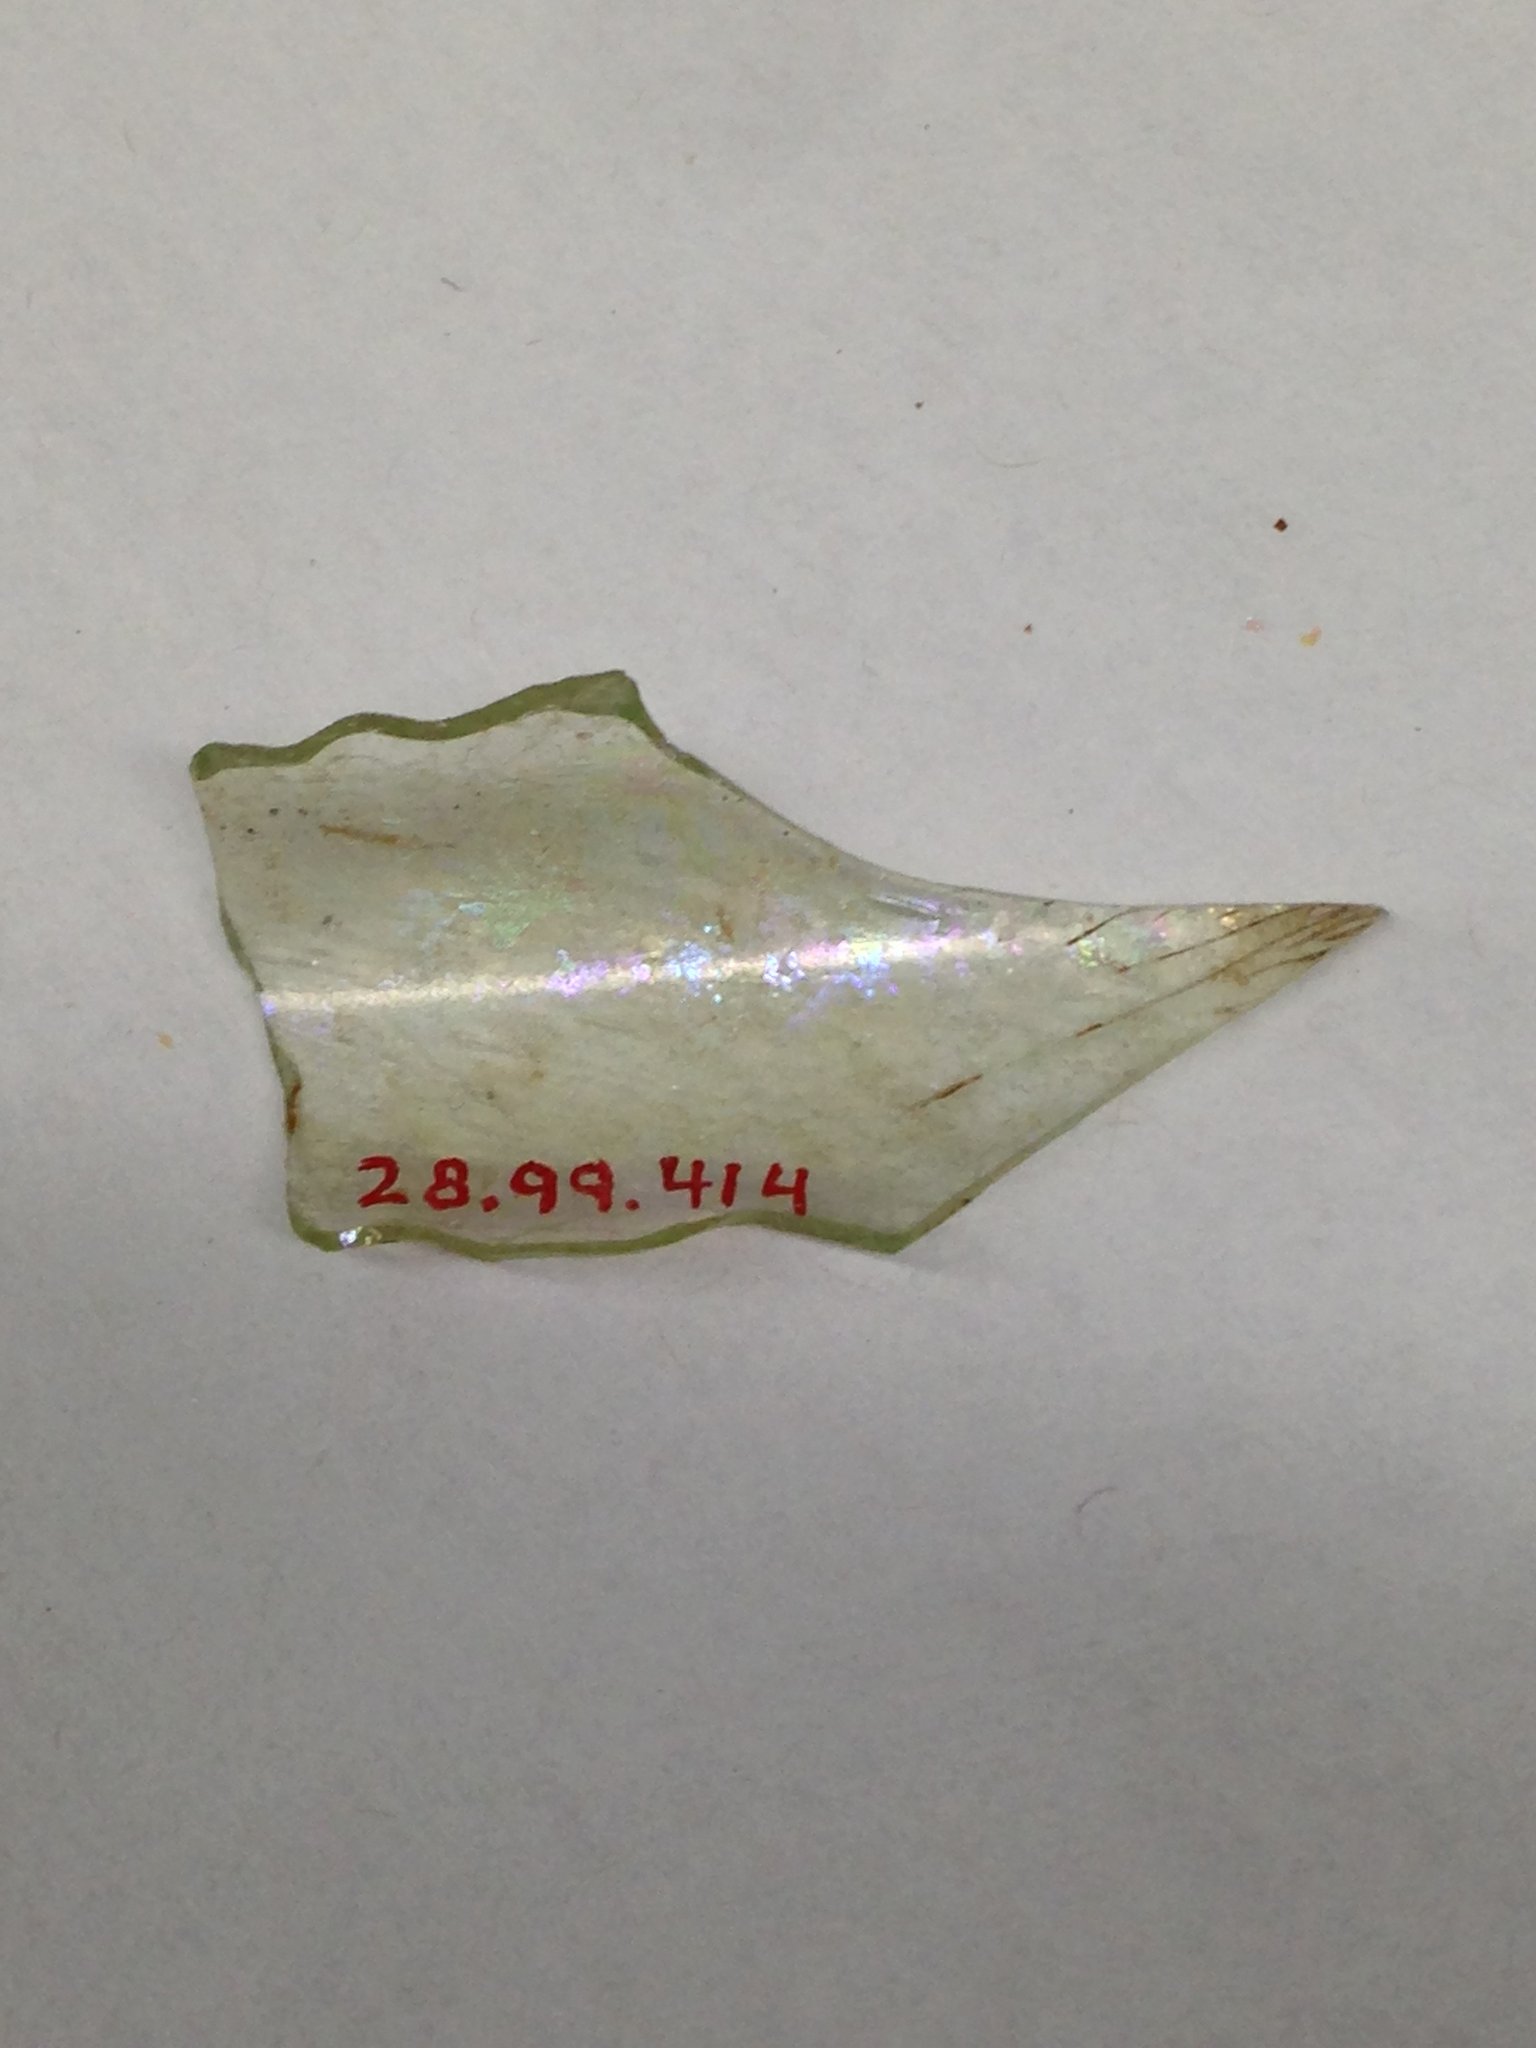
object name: fragment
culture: european or middle eastern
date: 1150-1250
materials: ceramic, glass